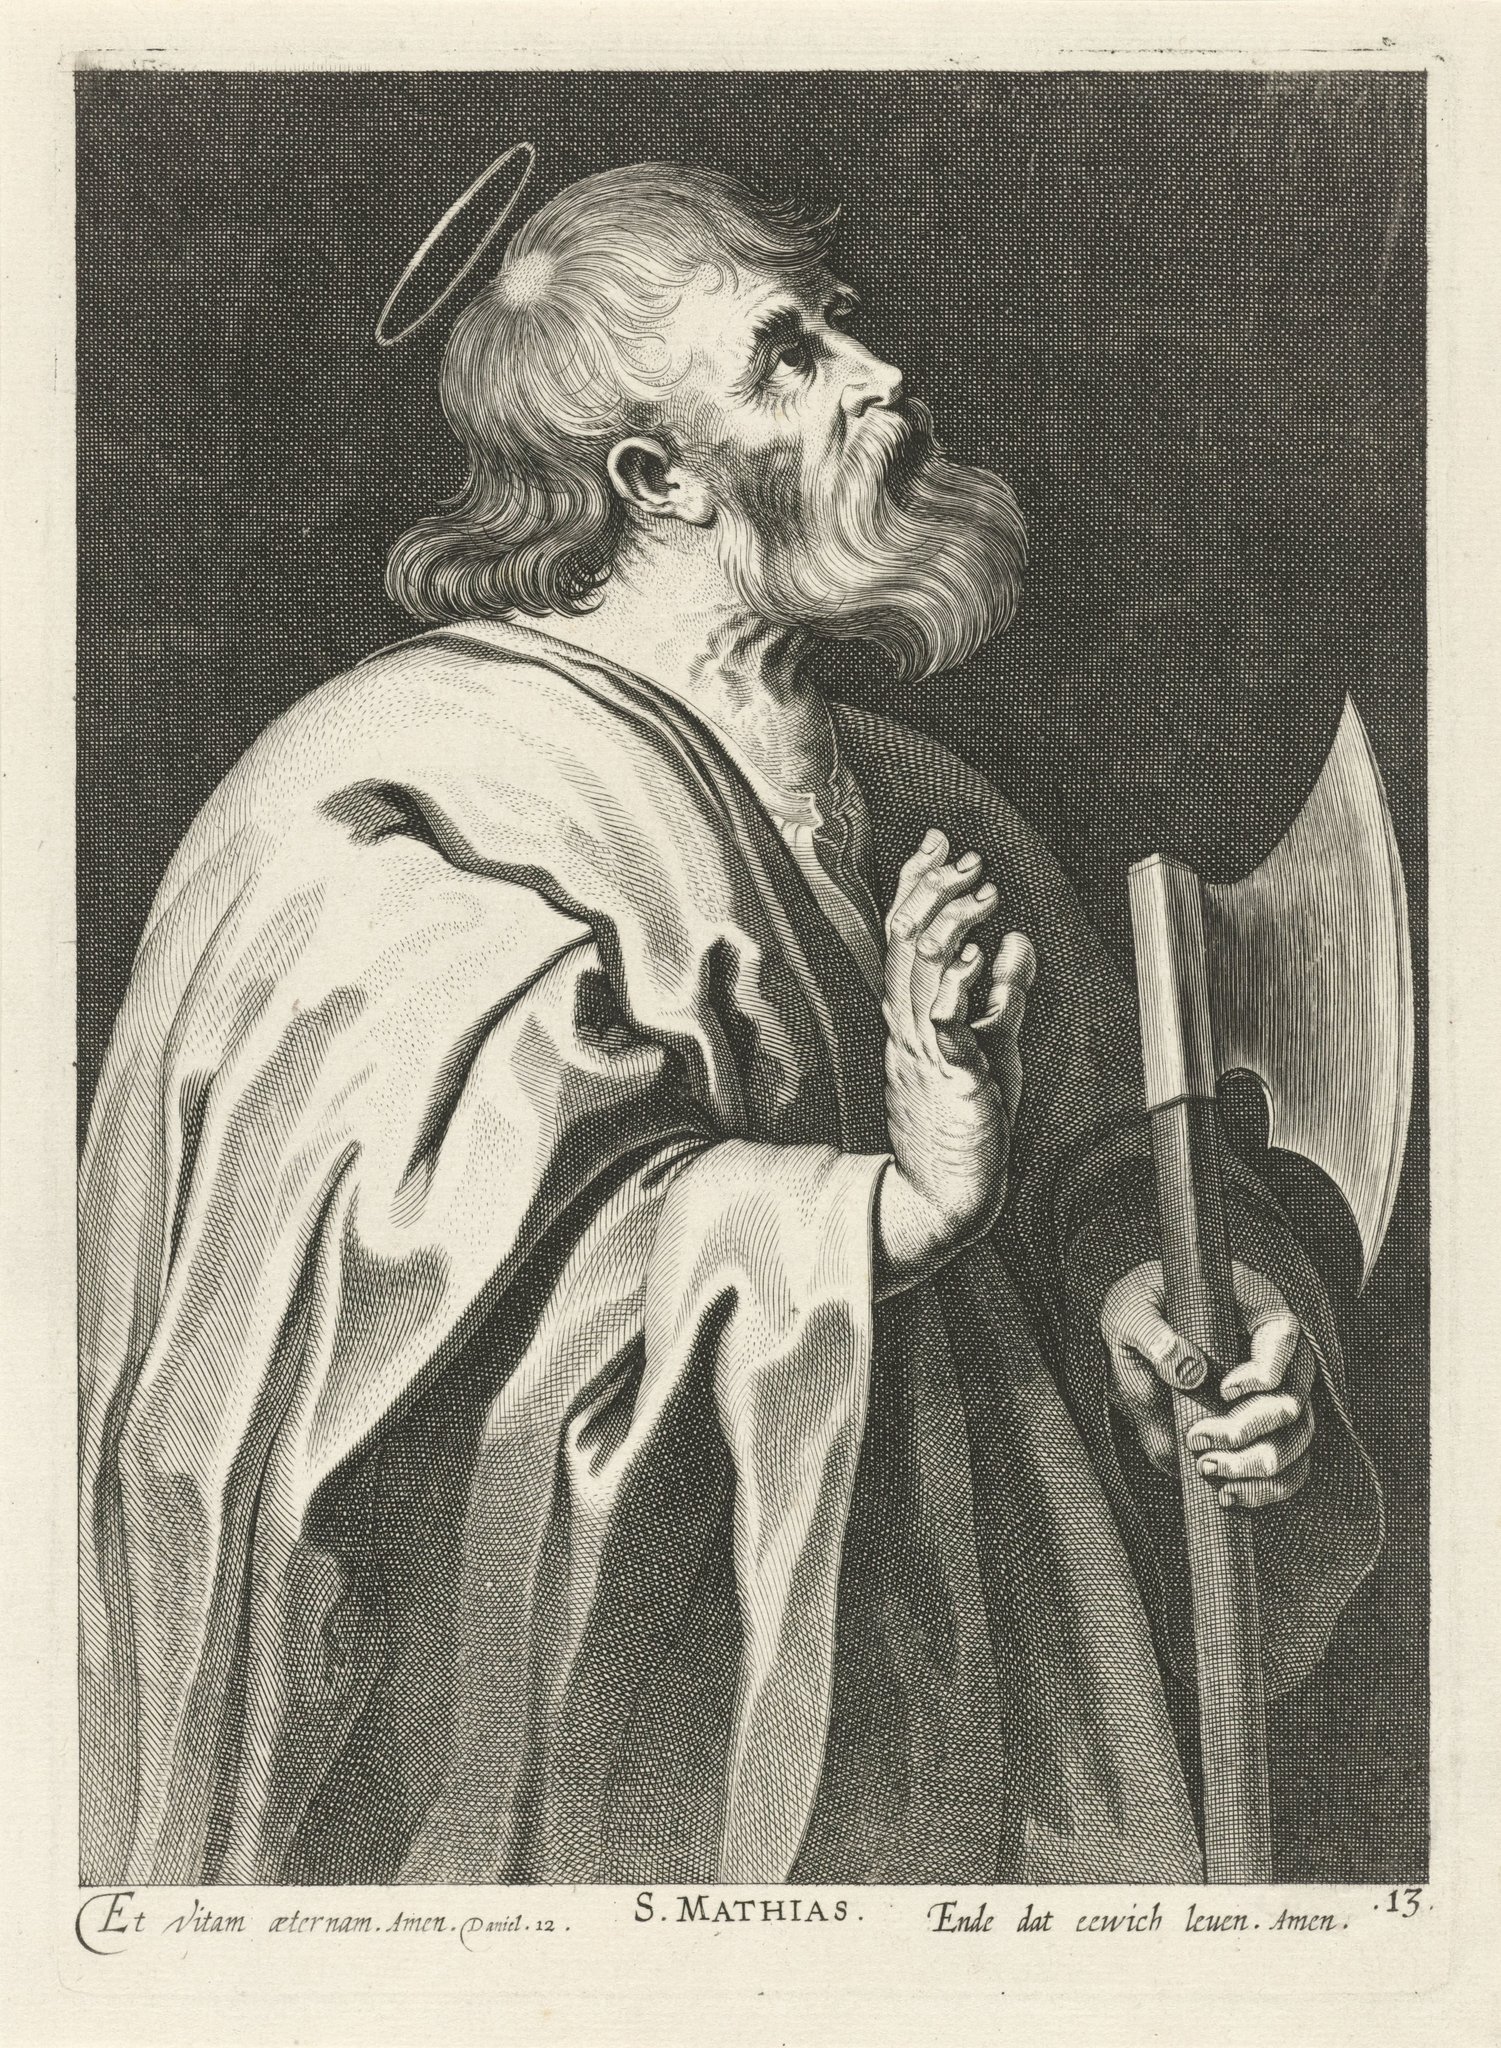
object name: print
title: Apostel Mattias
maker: nicolaes ryckmans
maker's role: print maker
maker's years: 1595-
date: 1616-1636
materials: paper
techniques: engraving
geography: southern netherlands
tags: the apostle and martyr matthias; possible attributes: axe, book, cross, halberd, scroll, sword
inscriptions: collector's mark: Lugt 240